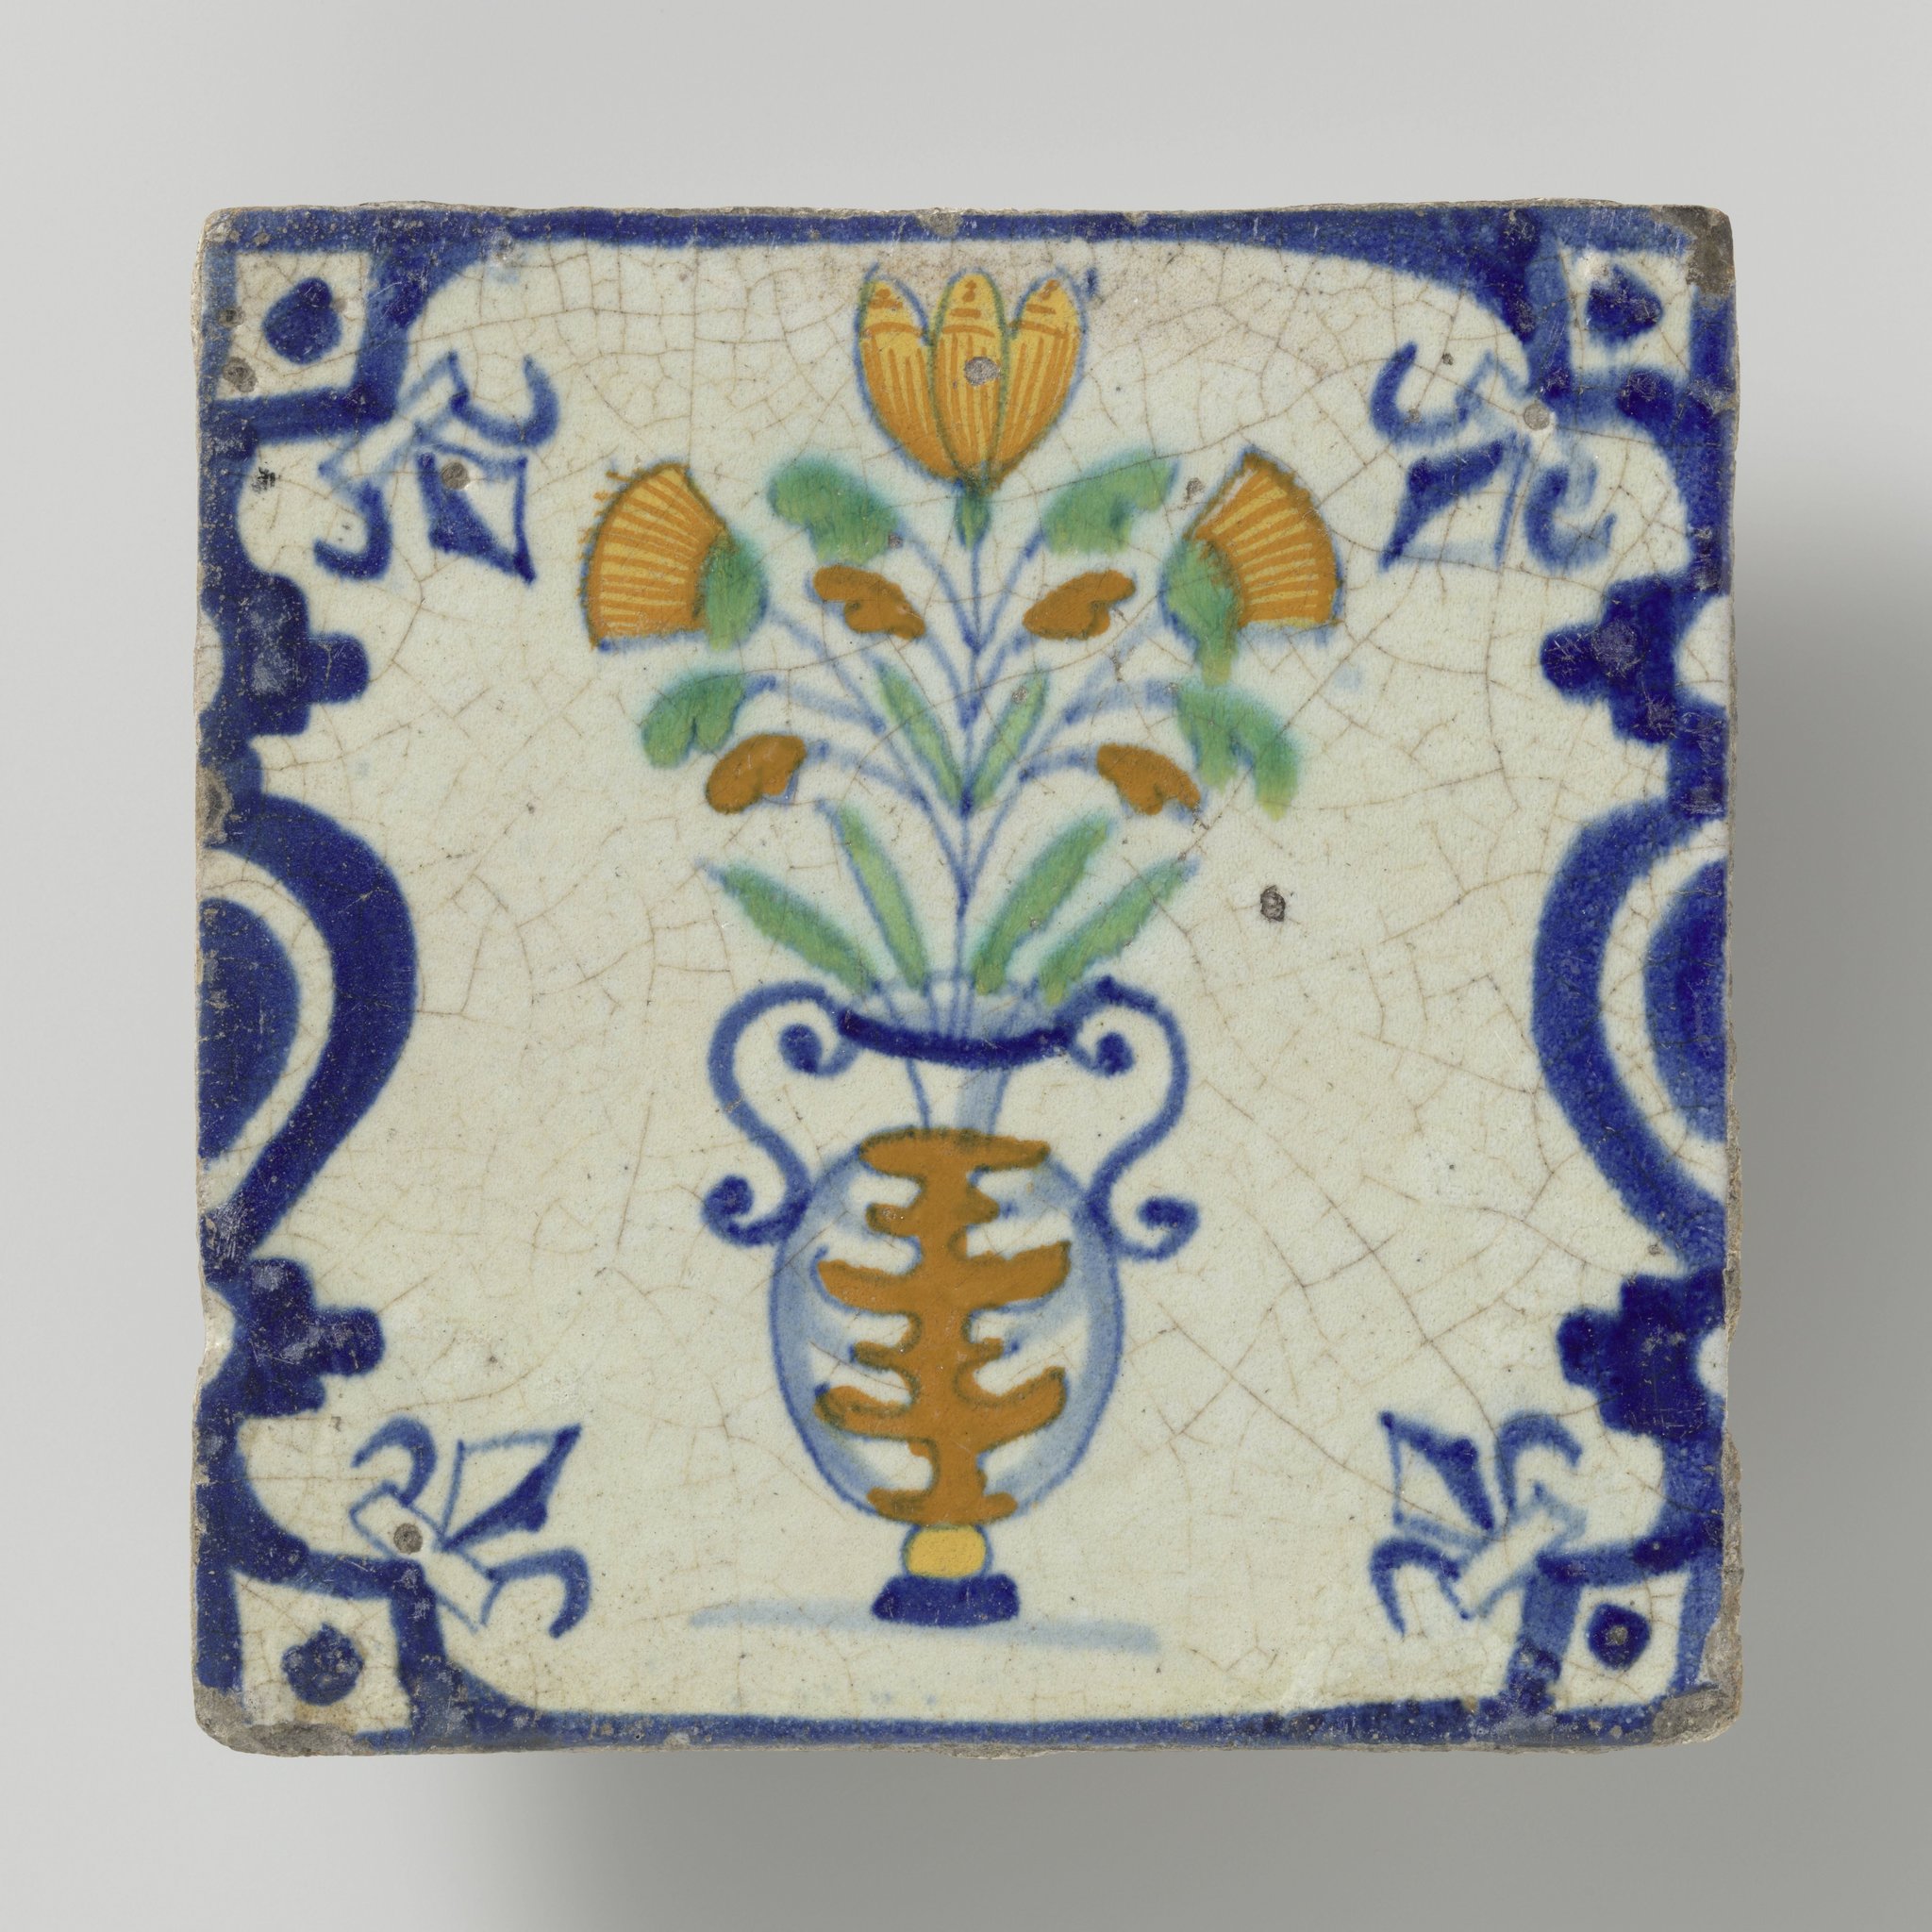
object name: tile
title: Tegel met bloempot tussen goudsbloemen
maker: Anonymous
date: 1625-1670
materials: earthenware, glaze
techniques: maiolica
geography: netherlands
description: Tegel met een veelkleurig (blauw, oranje, geel en groen) geschilderde bloempot met goudsbloemen. Aan weerskanten een kolom met lelies.